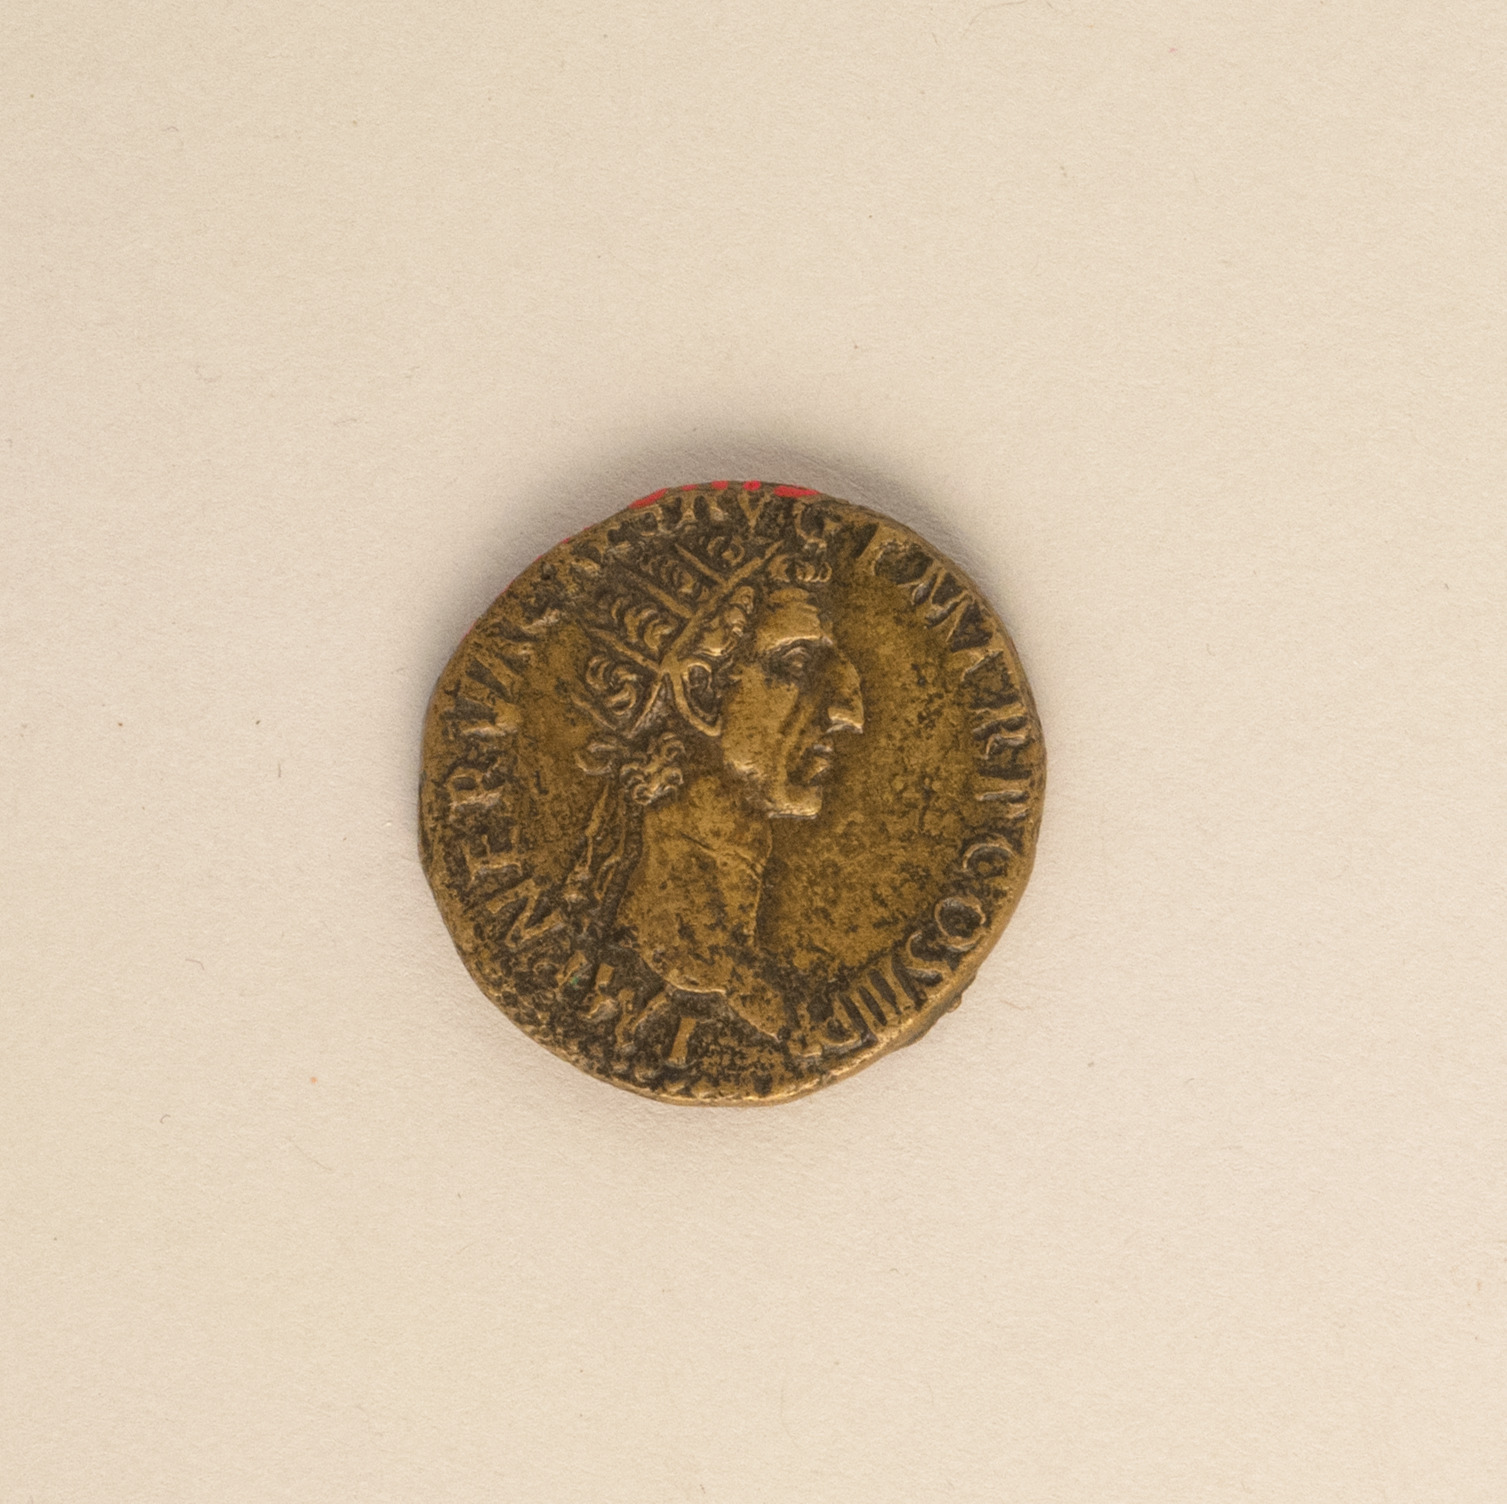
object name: dupondius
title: Bronze dupondius of Nerva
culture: roman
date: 97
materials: bronze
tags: men,profiles